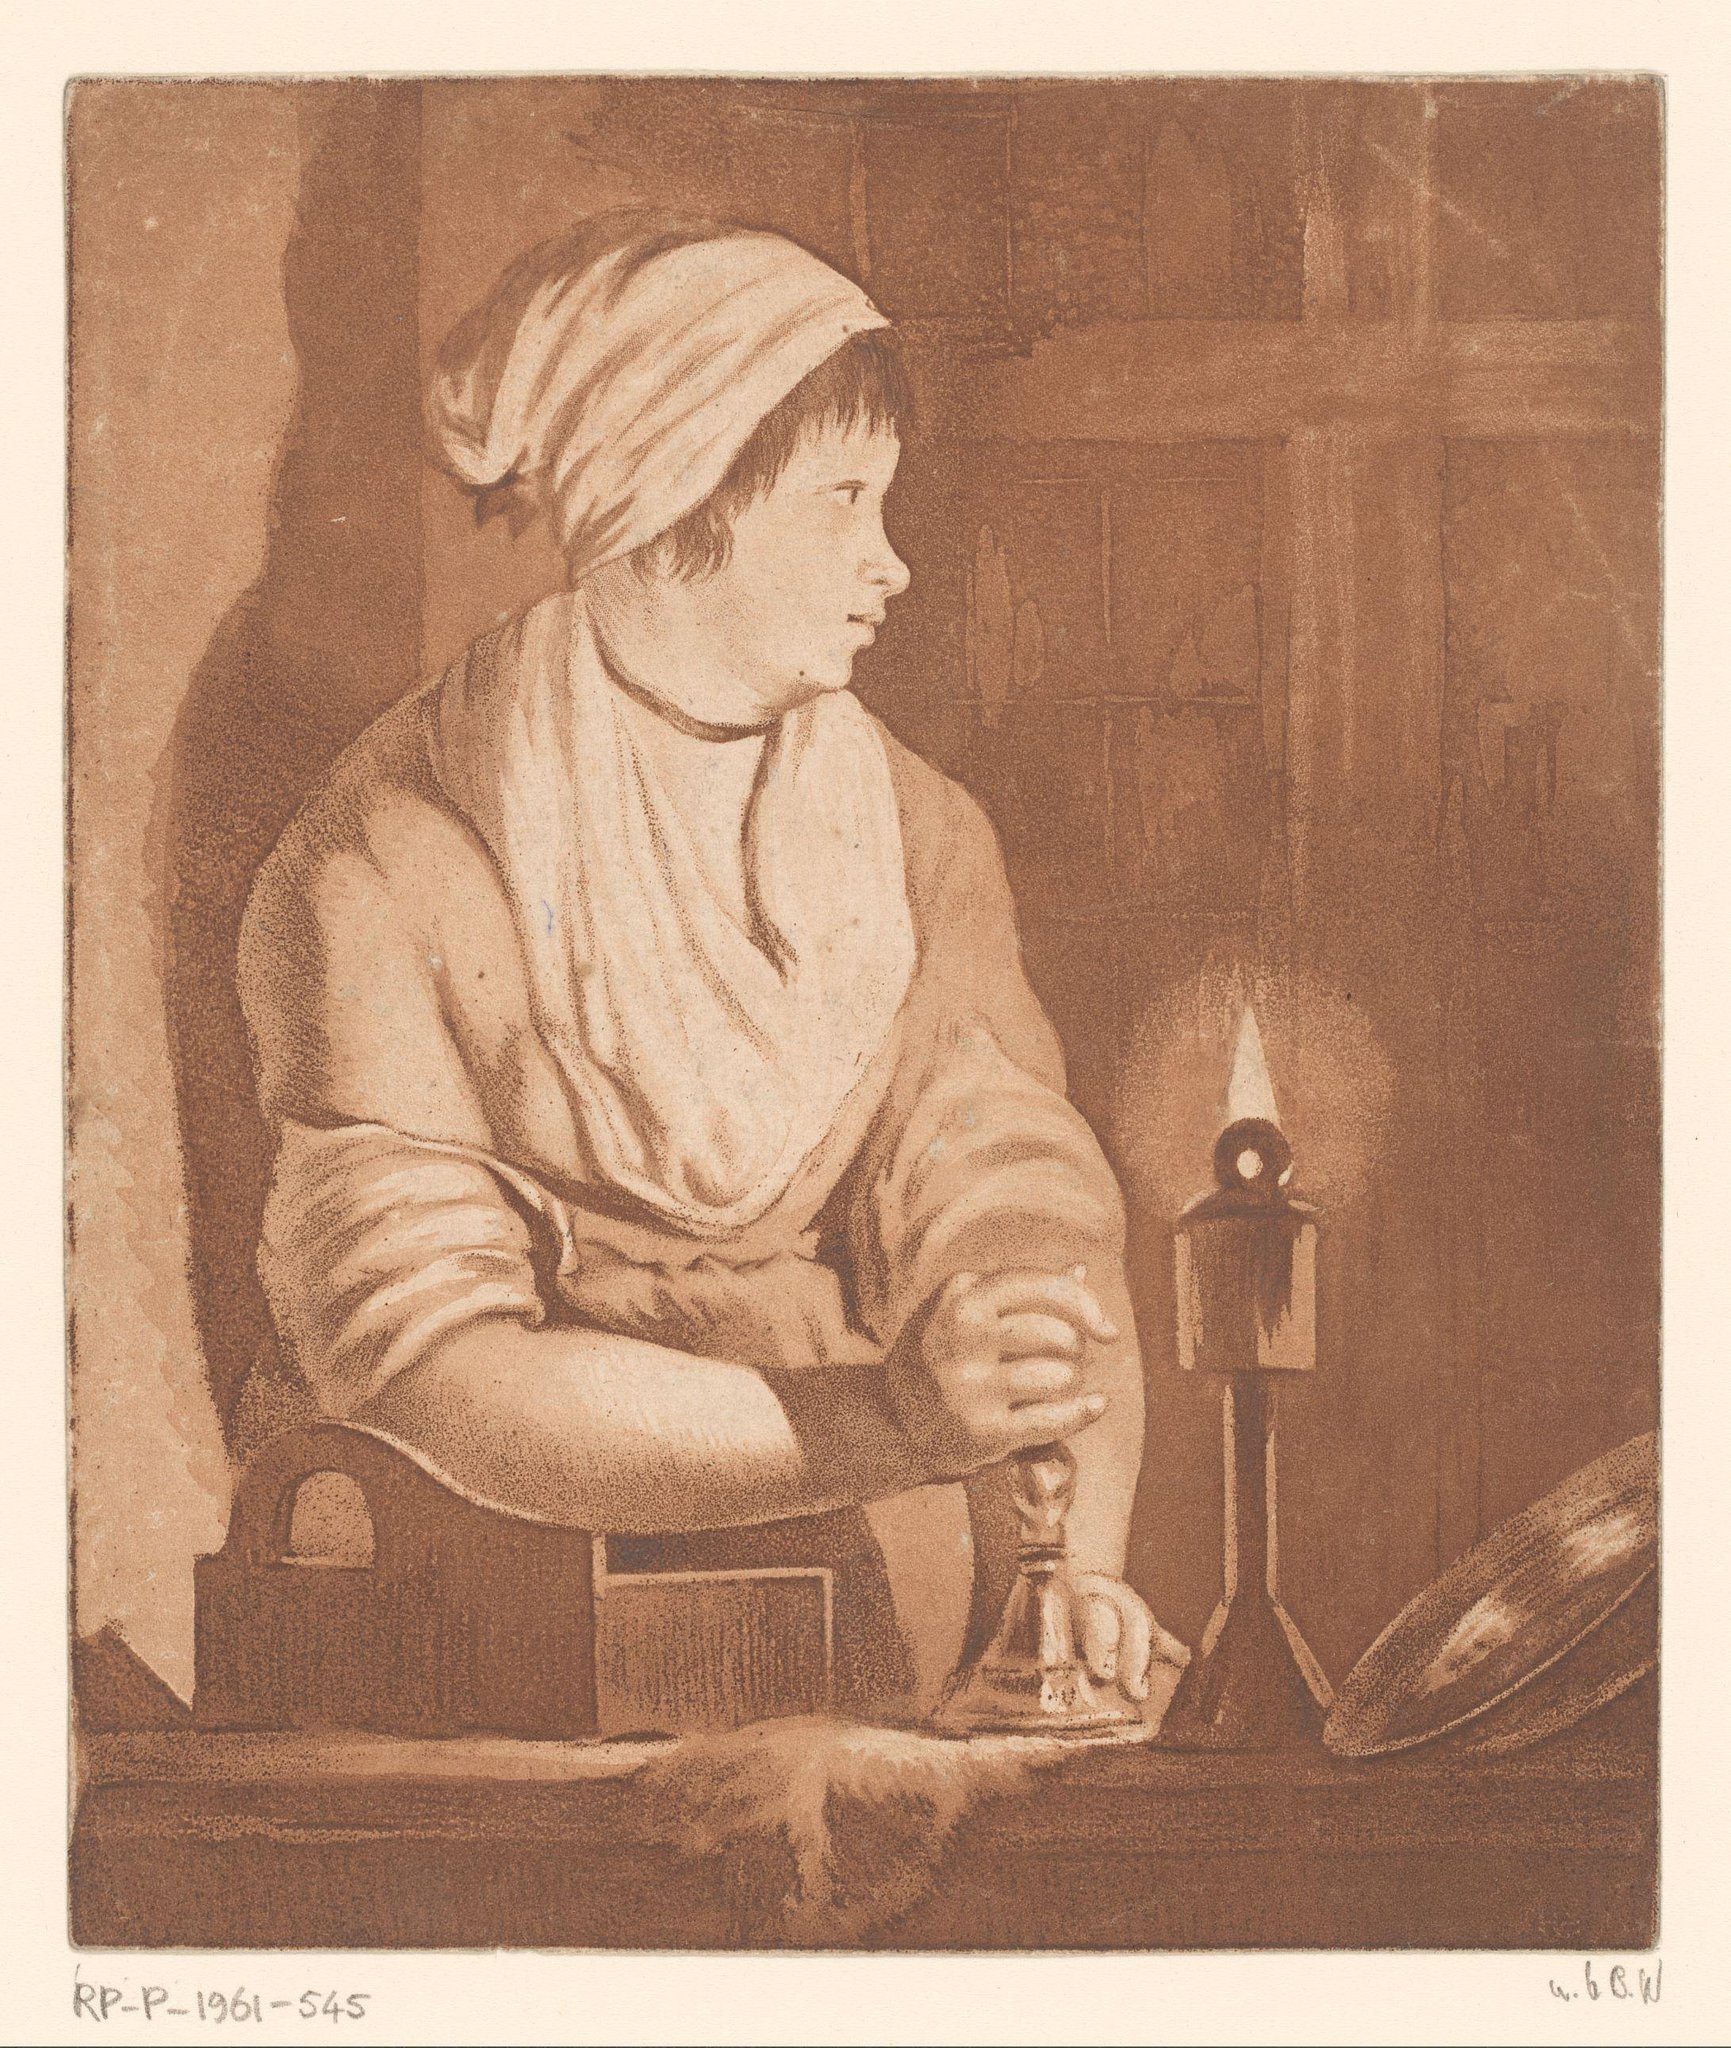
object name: print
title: Vrouw bij kaarslicht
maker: françois philippe charpentier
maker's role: print maker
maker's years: 1734-1817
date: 1744-1817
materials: paper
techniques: aquatint, etching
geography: france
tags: adult woman, candle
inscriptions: collector's mark: Lugt 2228, collector's mark: ‘"School voor de grafische vakken te Utrecht"’